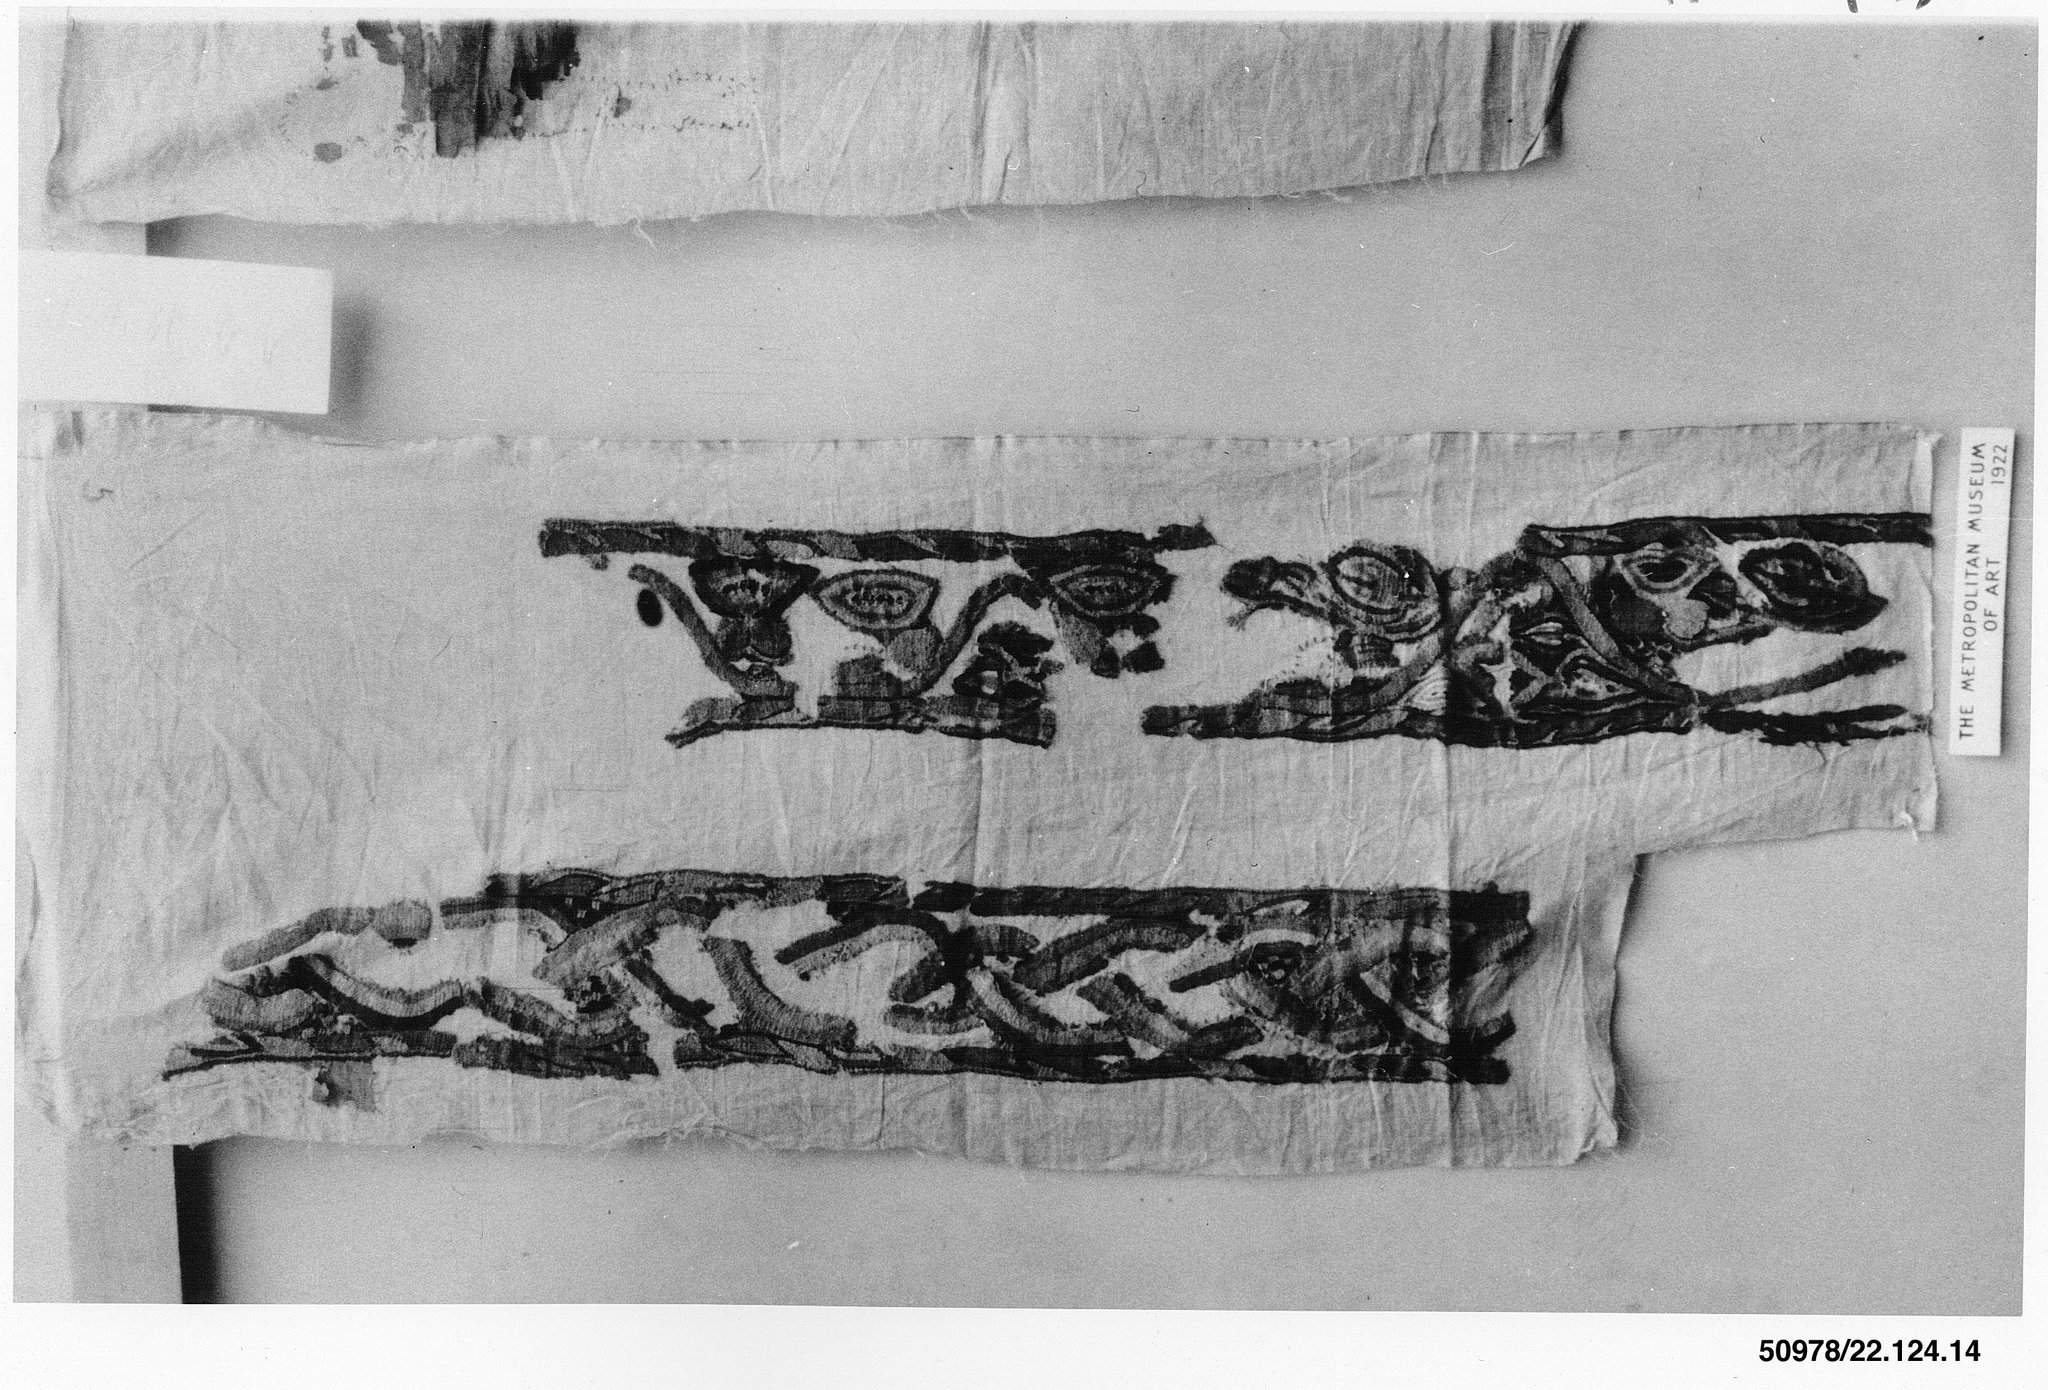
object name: fragment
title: Fragment of Band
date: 301-600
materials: linen, wool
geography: egypt